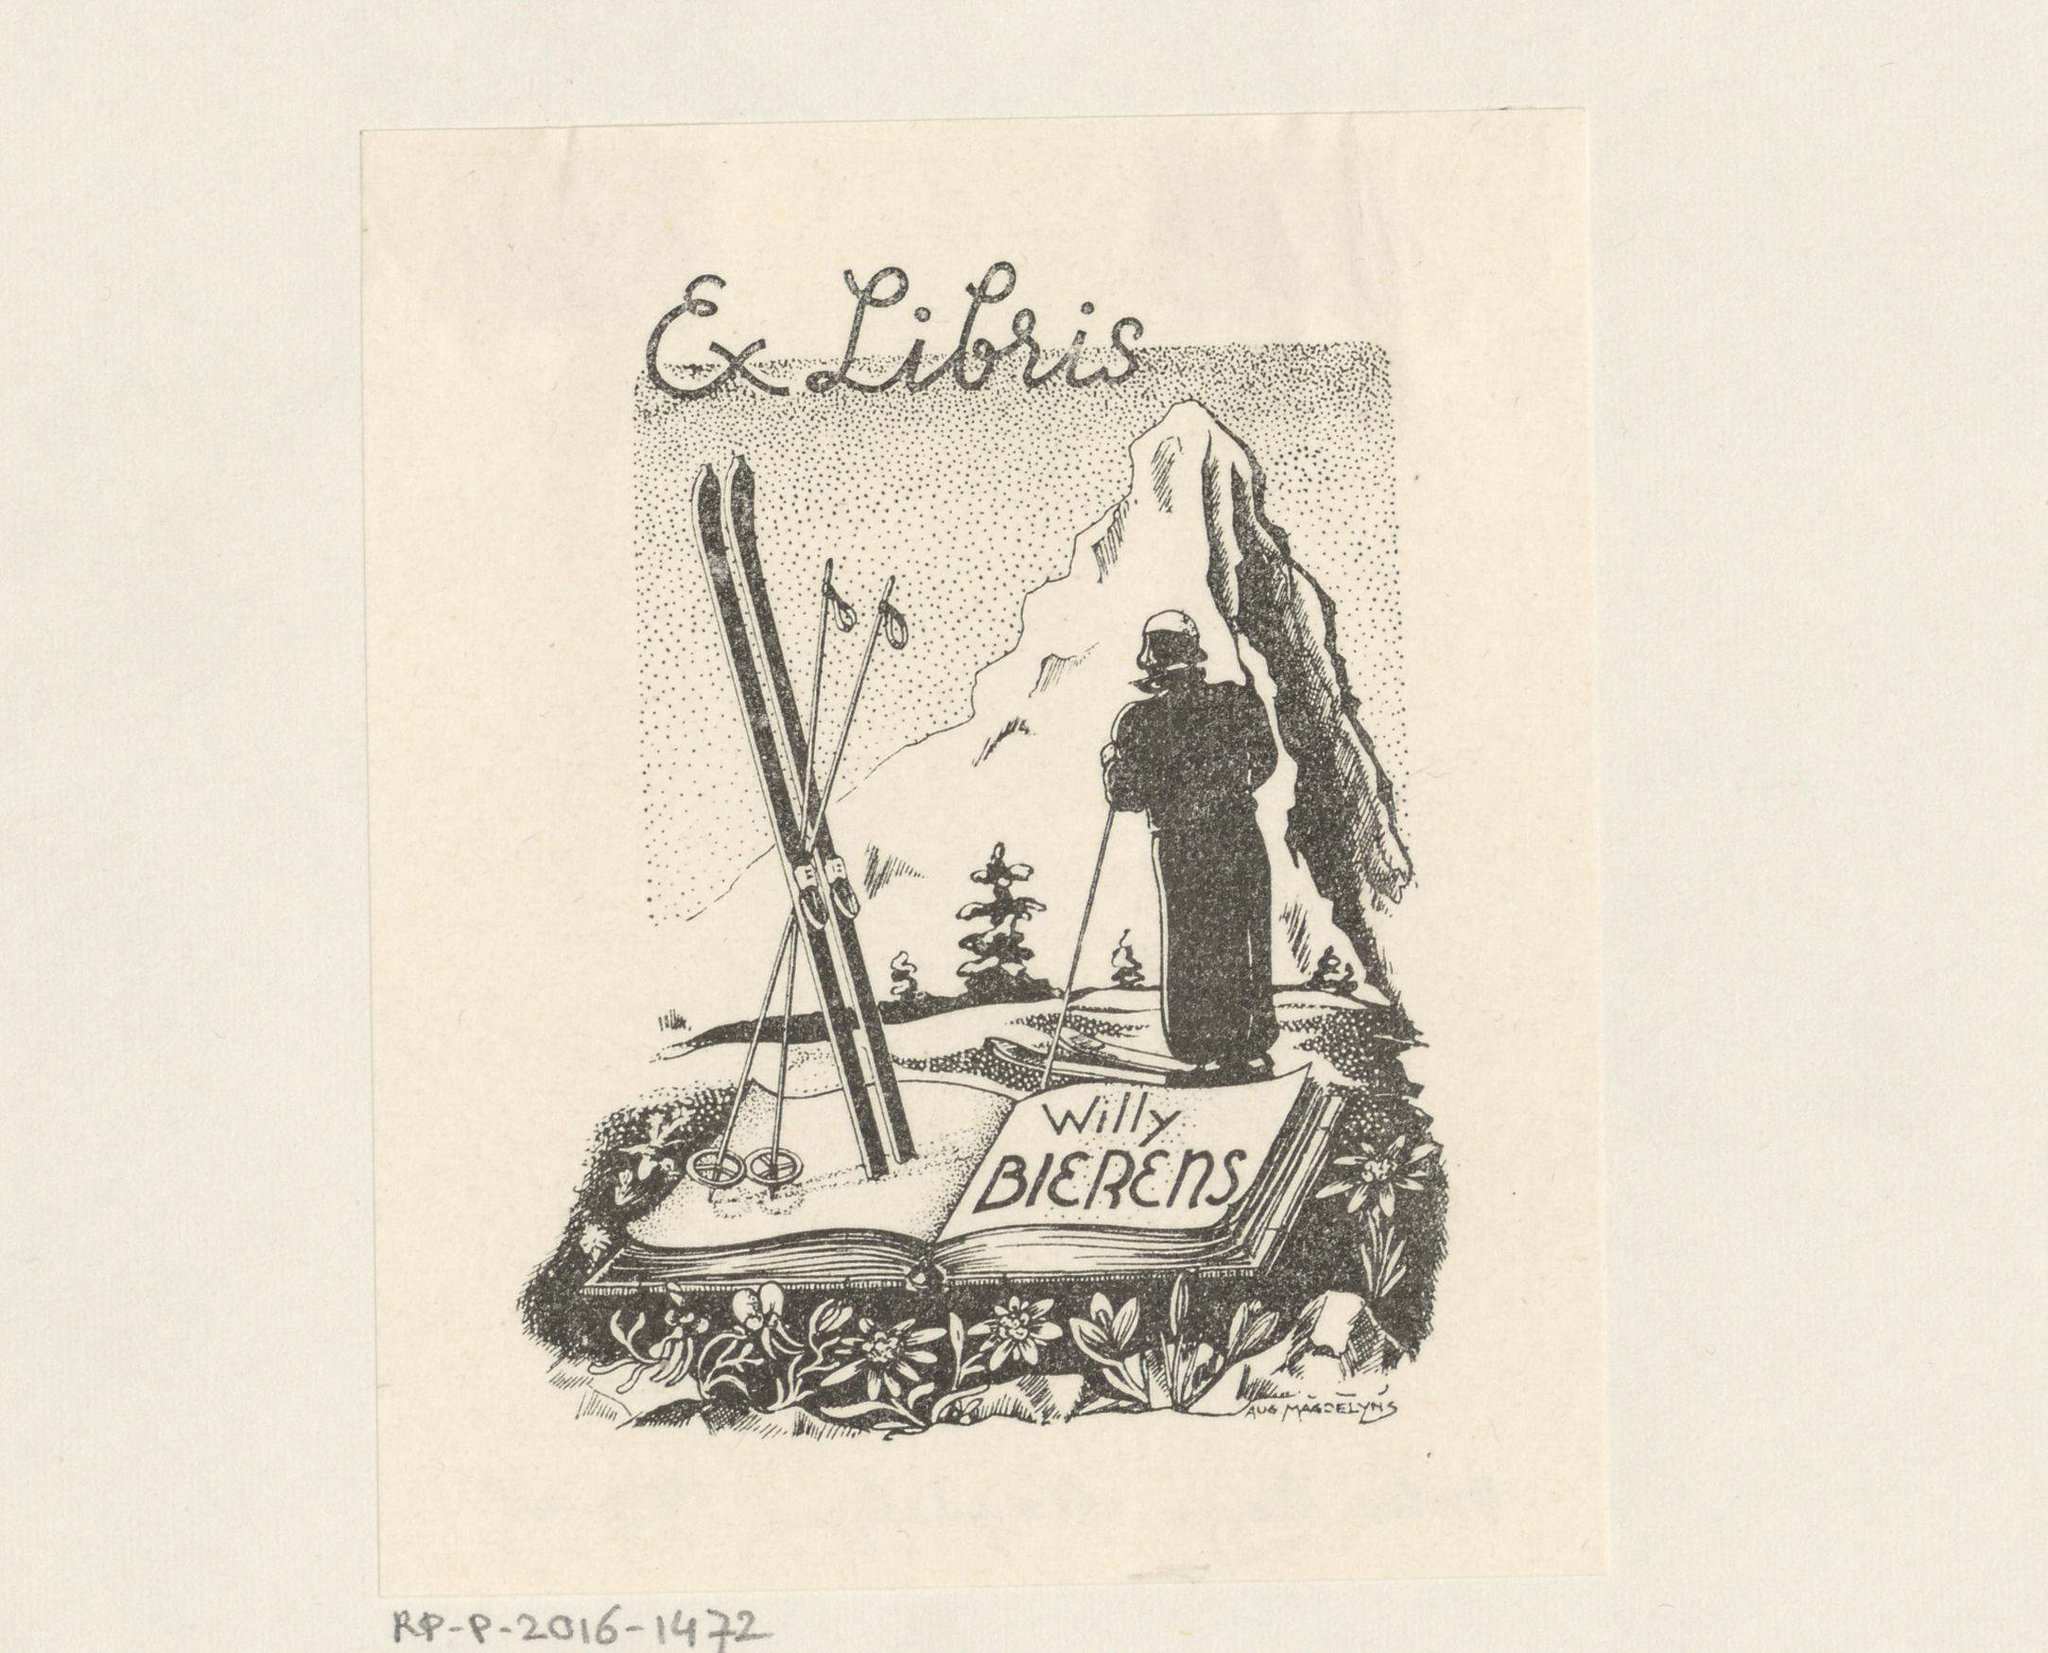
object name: bookplate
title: Ex libris van Willy Bierens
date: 1943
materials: paper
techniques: printing block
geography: netherlands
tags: skis (winter sports)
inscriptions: signature, date and inscription: ‘Ontw Aug. Magdelijns '43 cl.’